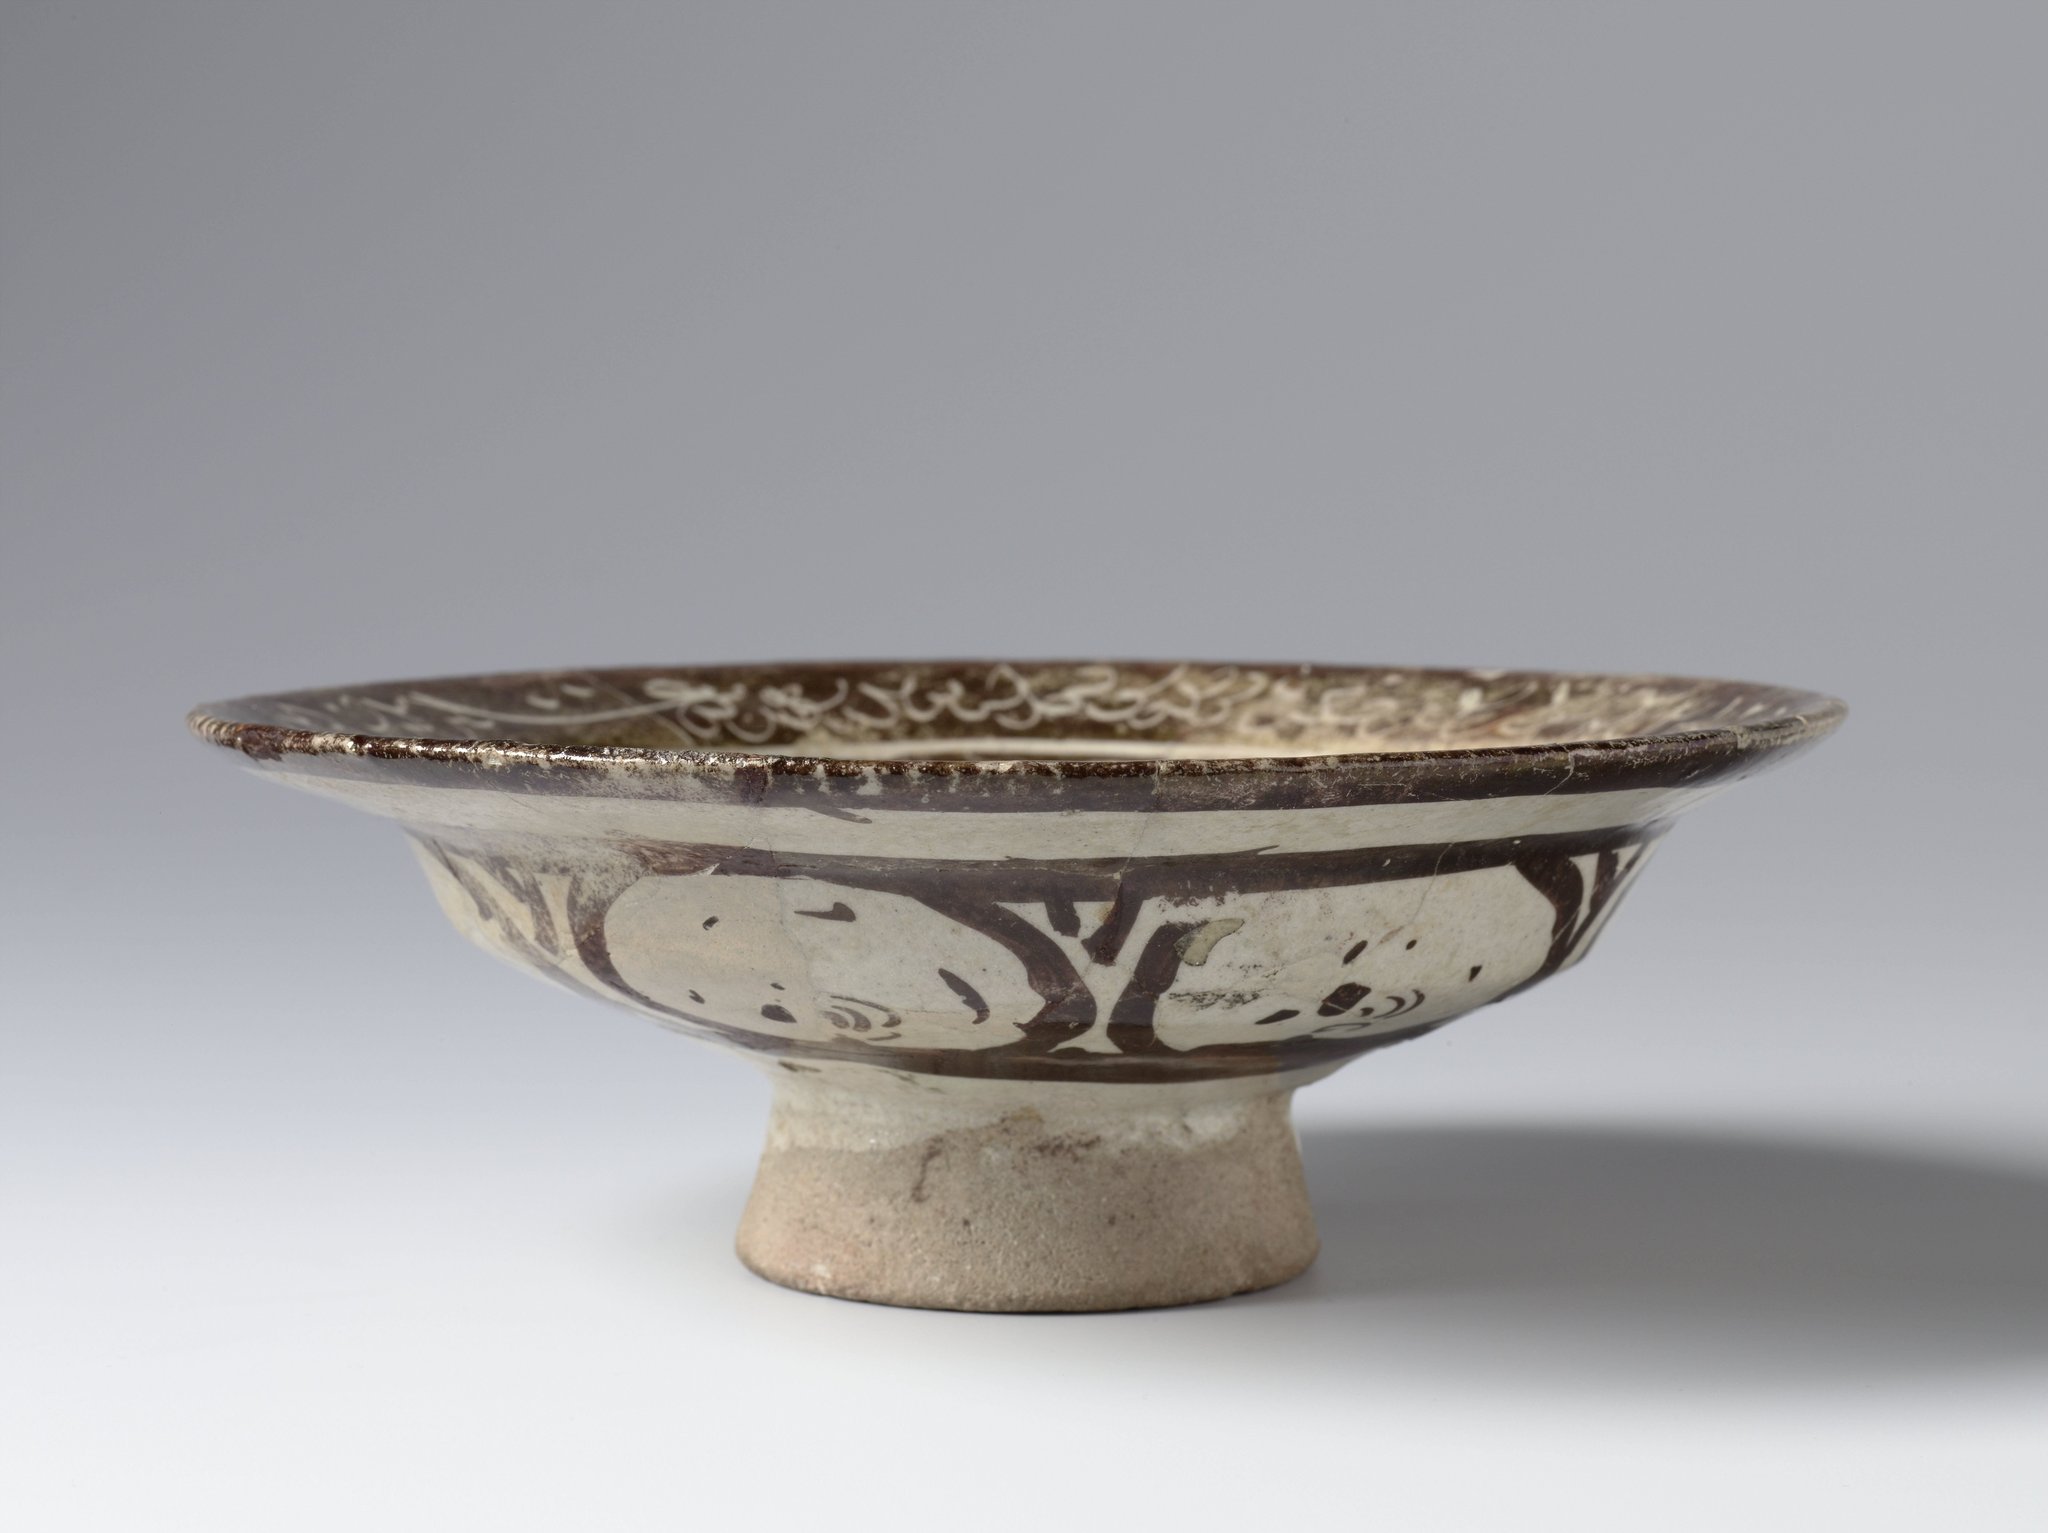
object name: bowl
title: Bowl with an inscription and hexagonals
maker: Anonymous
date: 1200-1220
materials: earthenware, glaze, luster, paint, quartz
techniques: firing, turning, vitrification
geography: kashan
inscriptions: inscription: ‘aan binnenzijde: twee teksten in Perzisch of Arabisch schrift.’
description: Kom van kwarts-fritgoed met hoge standring, beschilderd in luster met aan de buitenzijde lijnen en medaillons en aan de binnenzijde twee teksten in Perzisch of Arabisch schrift, gedeeltelijk ingegrift. In het plat in een roodachtige luster uitgespaarde zeshoeken.